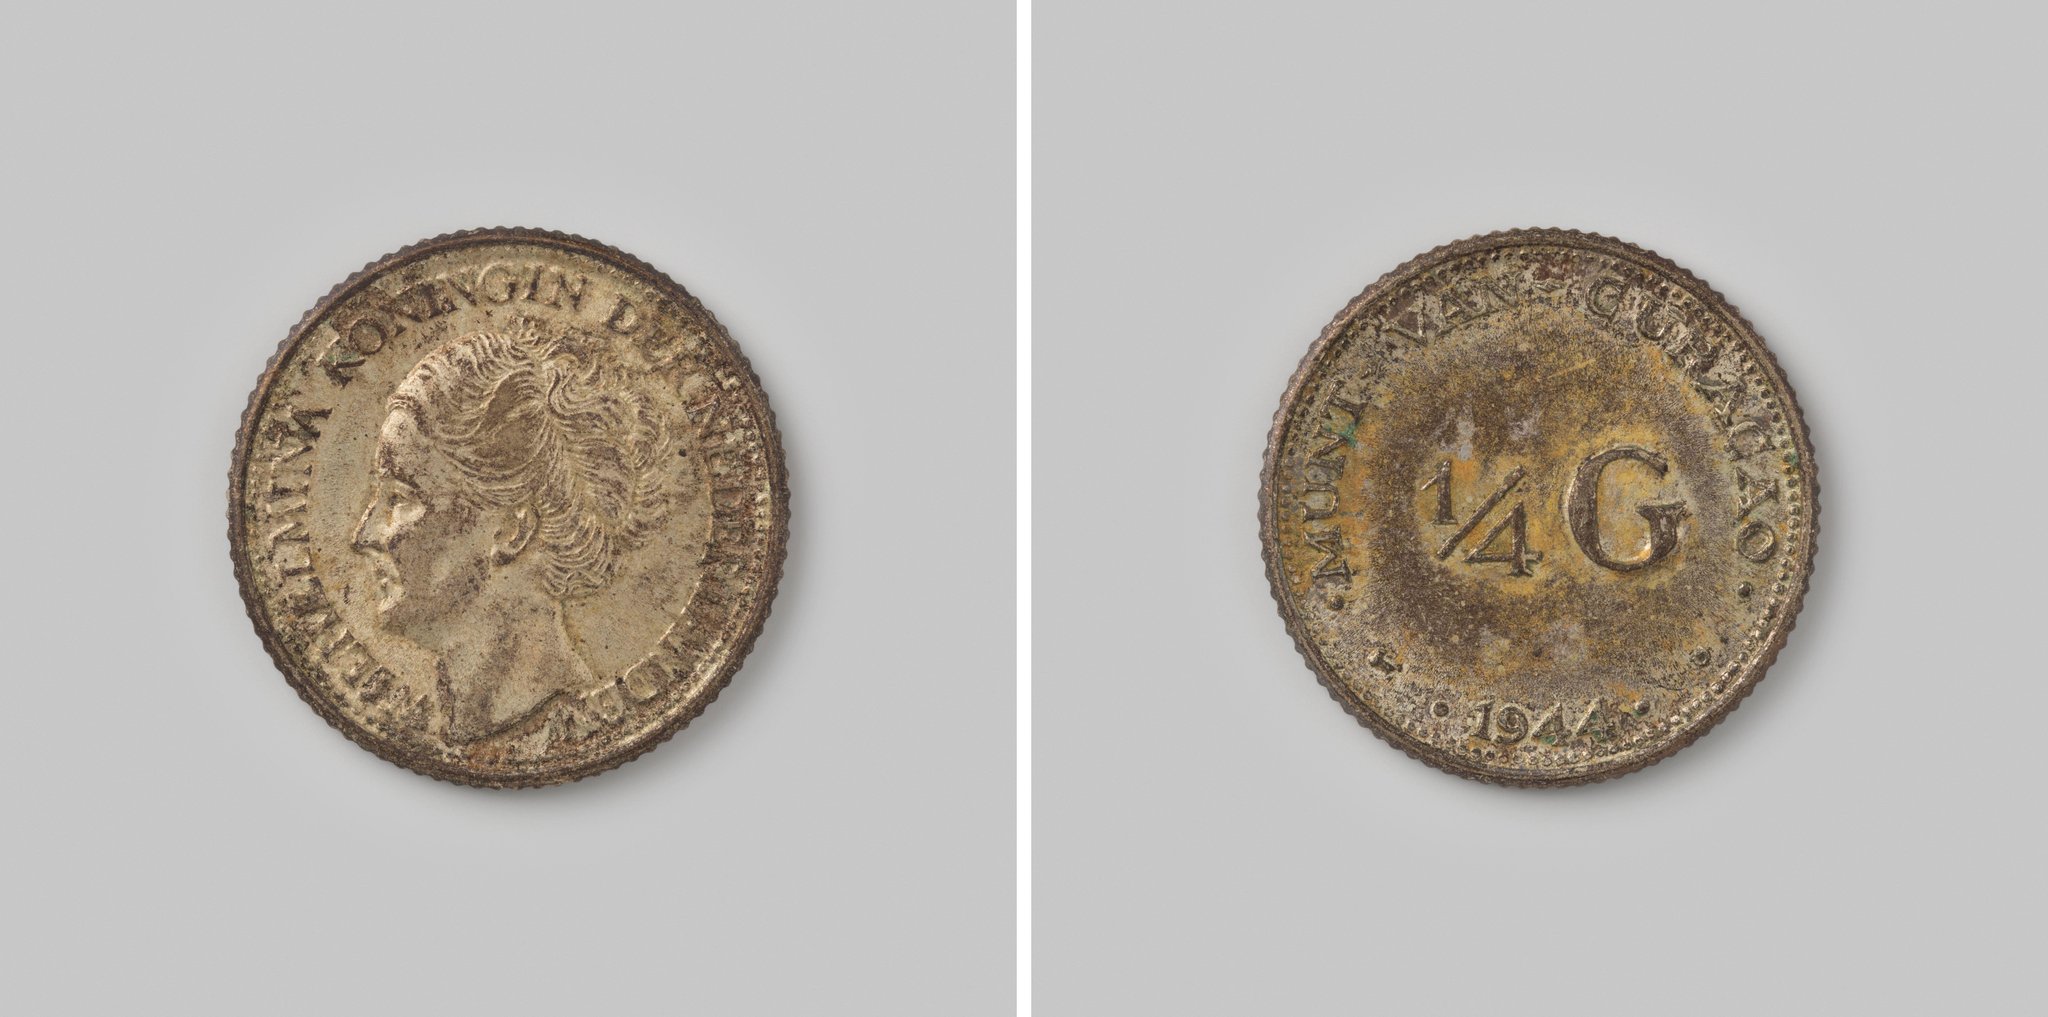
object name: coin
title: 1/4 gulden van Curacao, 1944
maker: wilhelmina of the netherlands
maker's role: print maker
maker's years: 1880-1962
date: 1944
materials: silver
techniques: striking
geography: denver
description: Zilveren munt. Voorzijde: hoofd naar links. Keerzijde: op een regel waarde-aanduiding 1/4 G. Omschrift: Munt van Curacao. Onderaan in omschrift tussen palmboom en letter D [=Denver] jaartal. Randschrift.